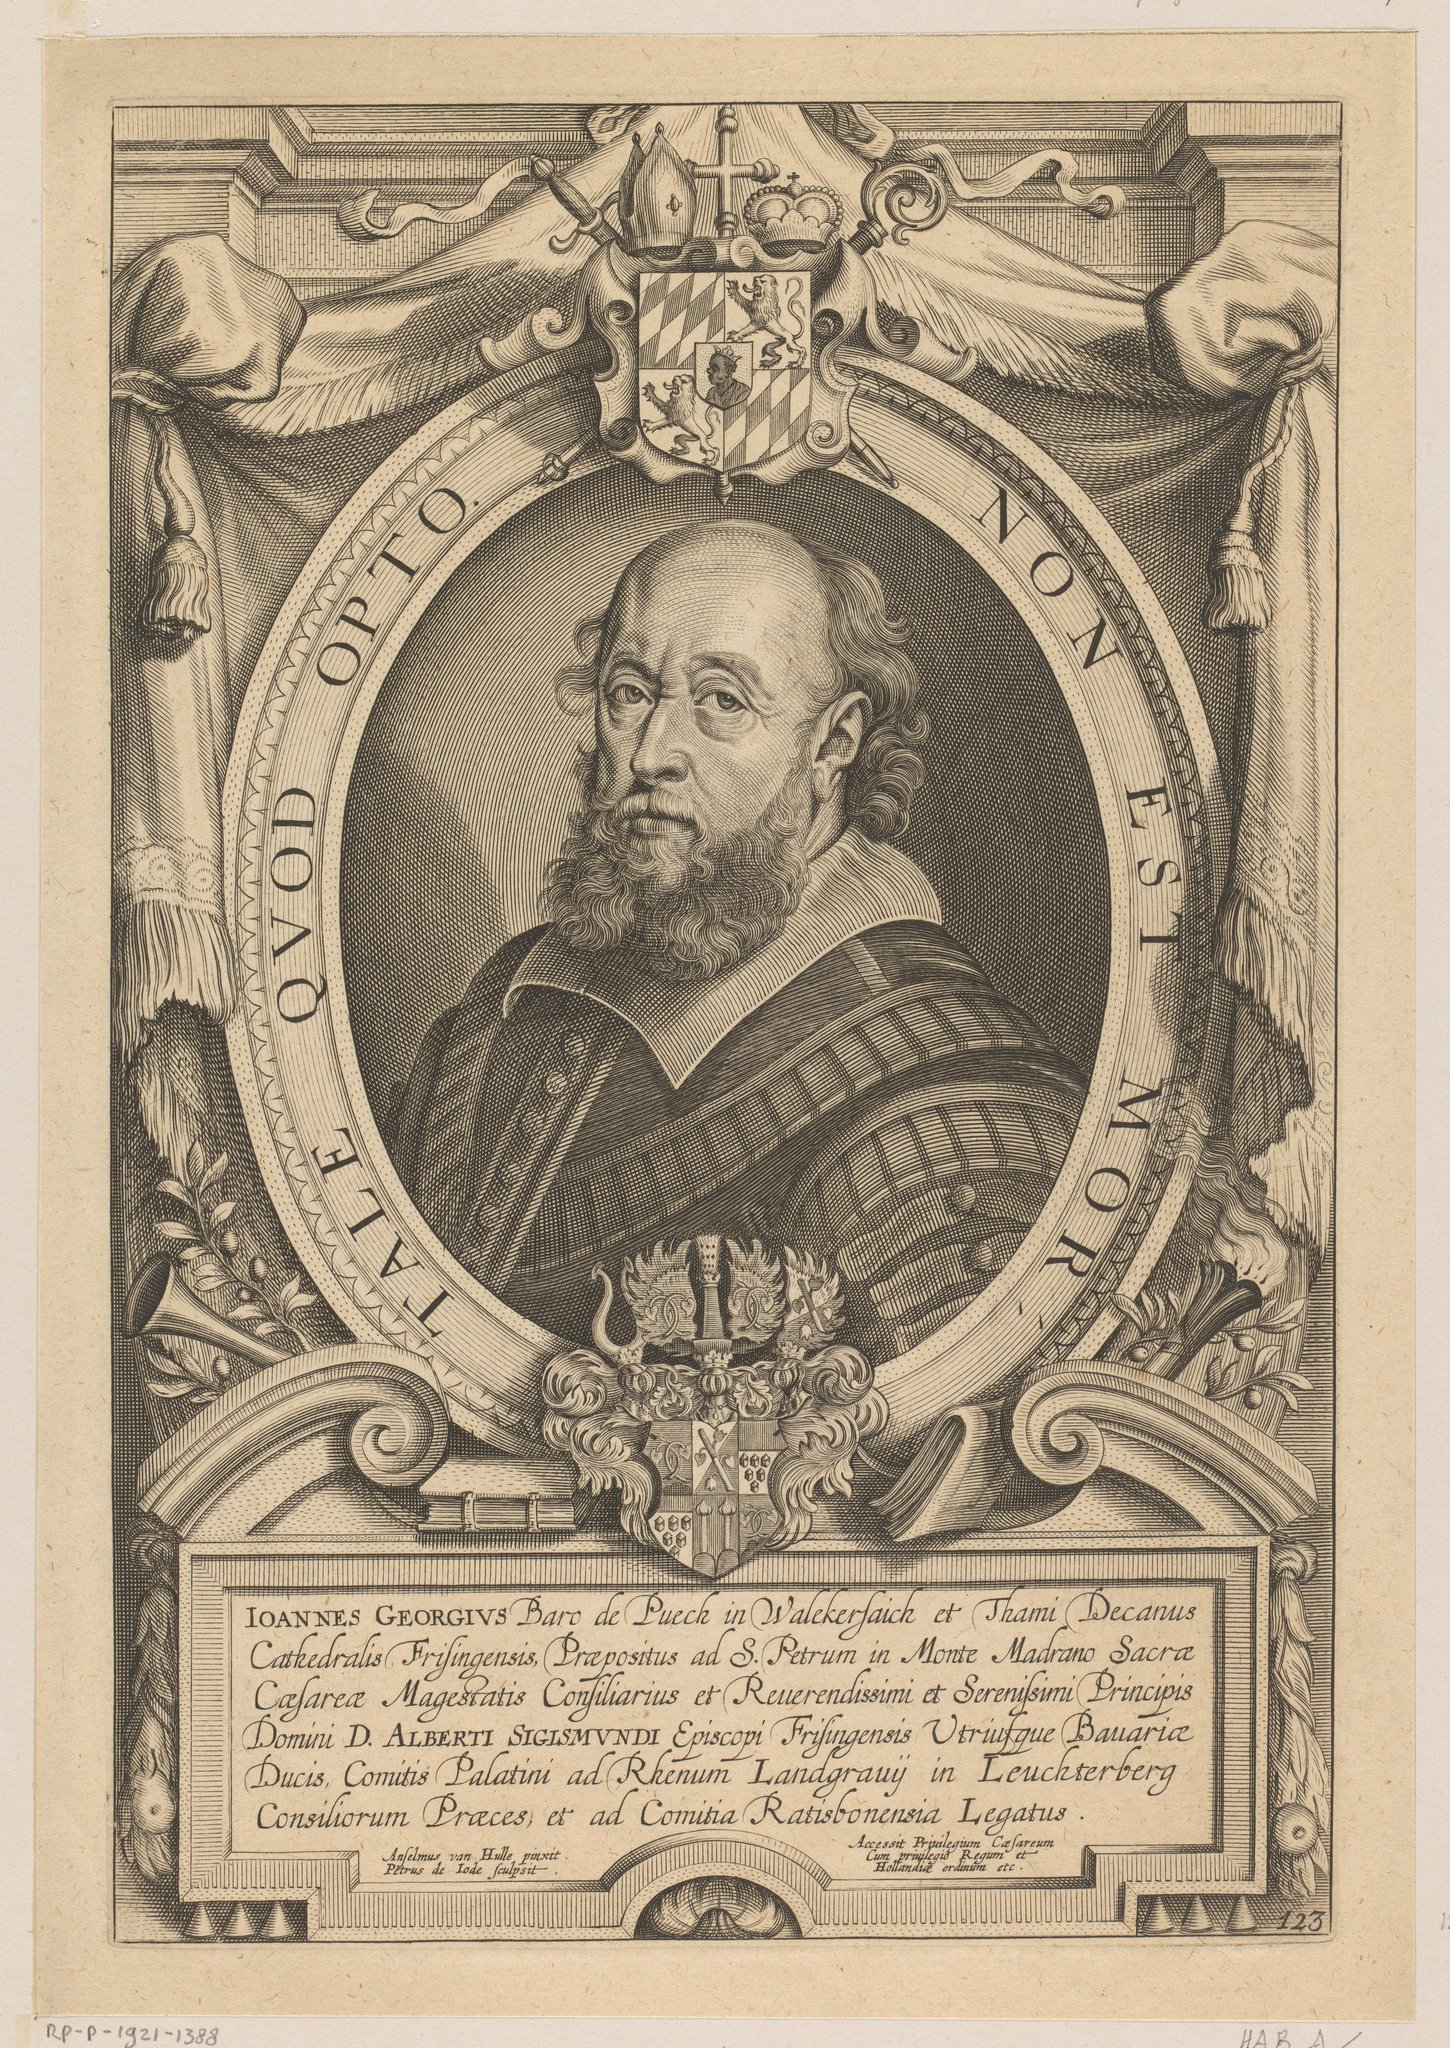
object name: print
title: Ioannes Georgius Baro de Puech in Walekersaich et Thami decanus (...)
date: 1713-1717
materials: paper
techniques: engraving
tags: historical persons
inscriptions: collector's mark: Lugt 2233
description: Prent is gebruikt in verschillende series. De huidige staat is gebruikt in de hieronder vermelde serie en uitgaven (4) en (5). (1)‘Legati Celeberrimi', waarschijnlijk uitgegeven in 1658, maar opnieuw met de vermelding door Daniel Middeler in 1648 in Antwerpen. (2) 'Pacificatores orbis Christiani, sive icones principum, ducum et legatorum, qui Monasterii atque Osnabrugae (...)', uitgegeven door Pieter van der Slaart in 1696 in Rotterdam. (3) 'Pacificatores orbis Christiani, sive icones principum, ducum et legatorum, qui Monasterii atque Osnabrugae (...)', uitgegeven door Pieter van der Slaart in 1697 in Rotterdam. (4) 'Pacificatores orbis Christiani, sive icones principum, ducum et legatorum, qui Monasterii atque Osnabrugae (...)', waarschijnlijk uitgegeven circa 1713, maar opnieuw met vermelding van Pieter van der Slaart in 1697 in Rotterdam. De platen in deze uitgave zijn voor het eerst genummerd. (5) 'Les hommes illustres qui ont vécu dans le XXIIe siècle (...)', uitgegeven door David Mortier in 1717 in Rotterdam. Zie documentatie. Mogelijk zijn er nog meerdere uitgaven en staten van deze prent.